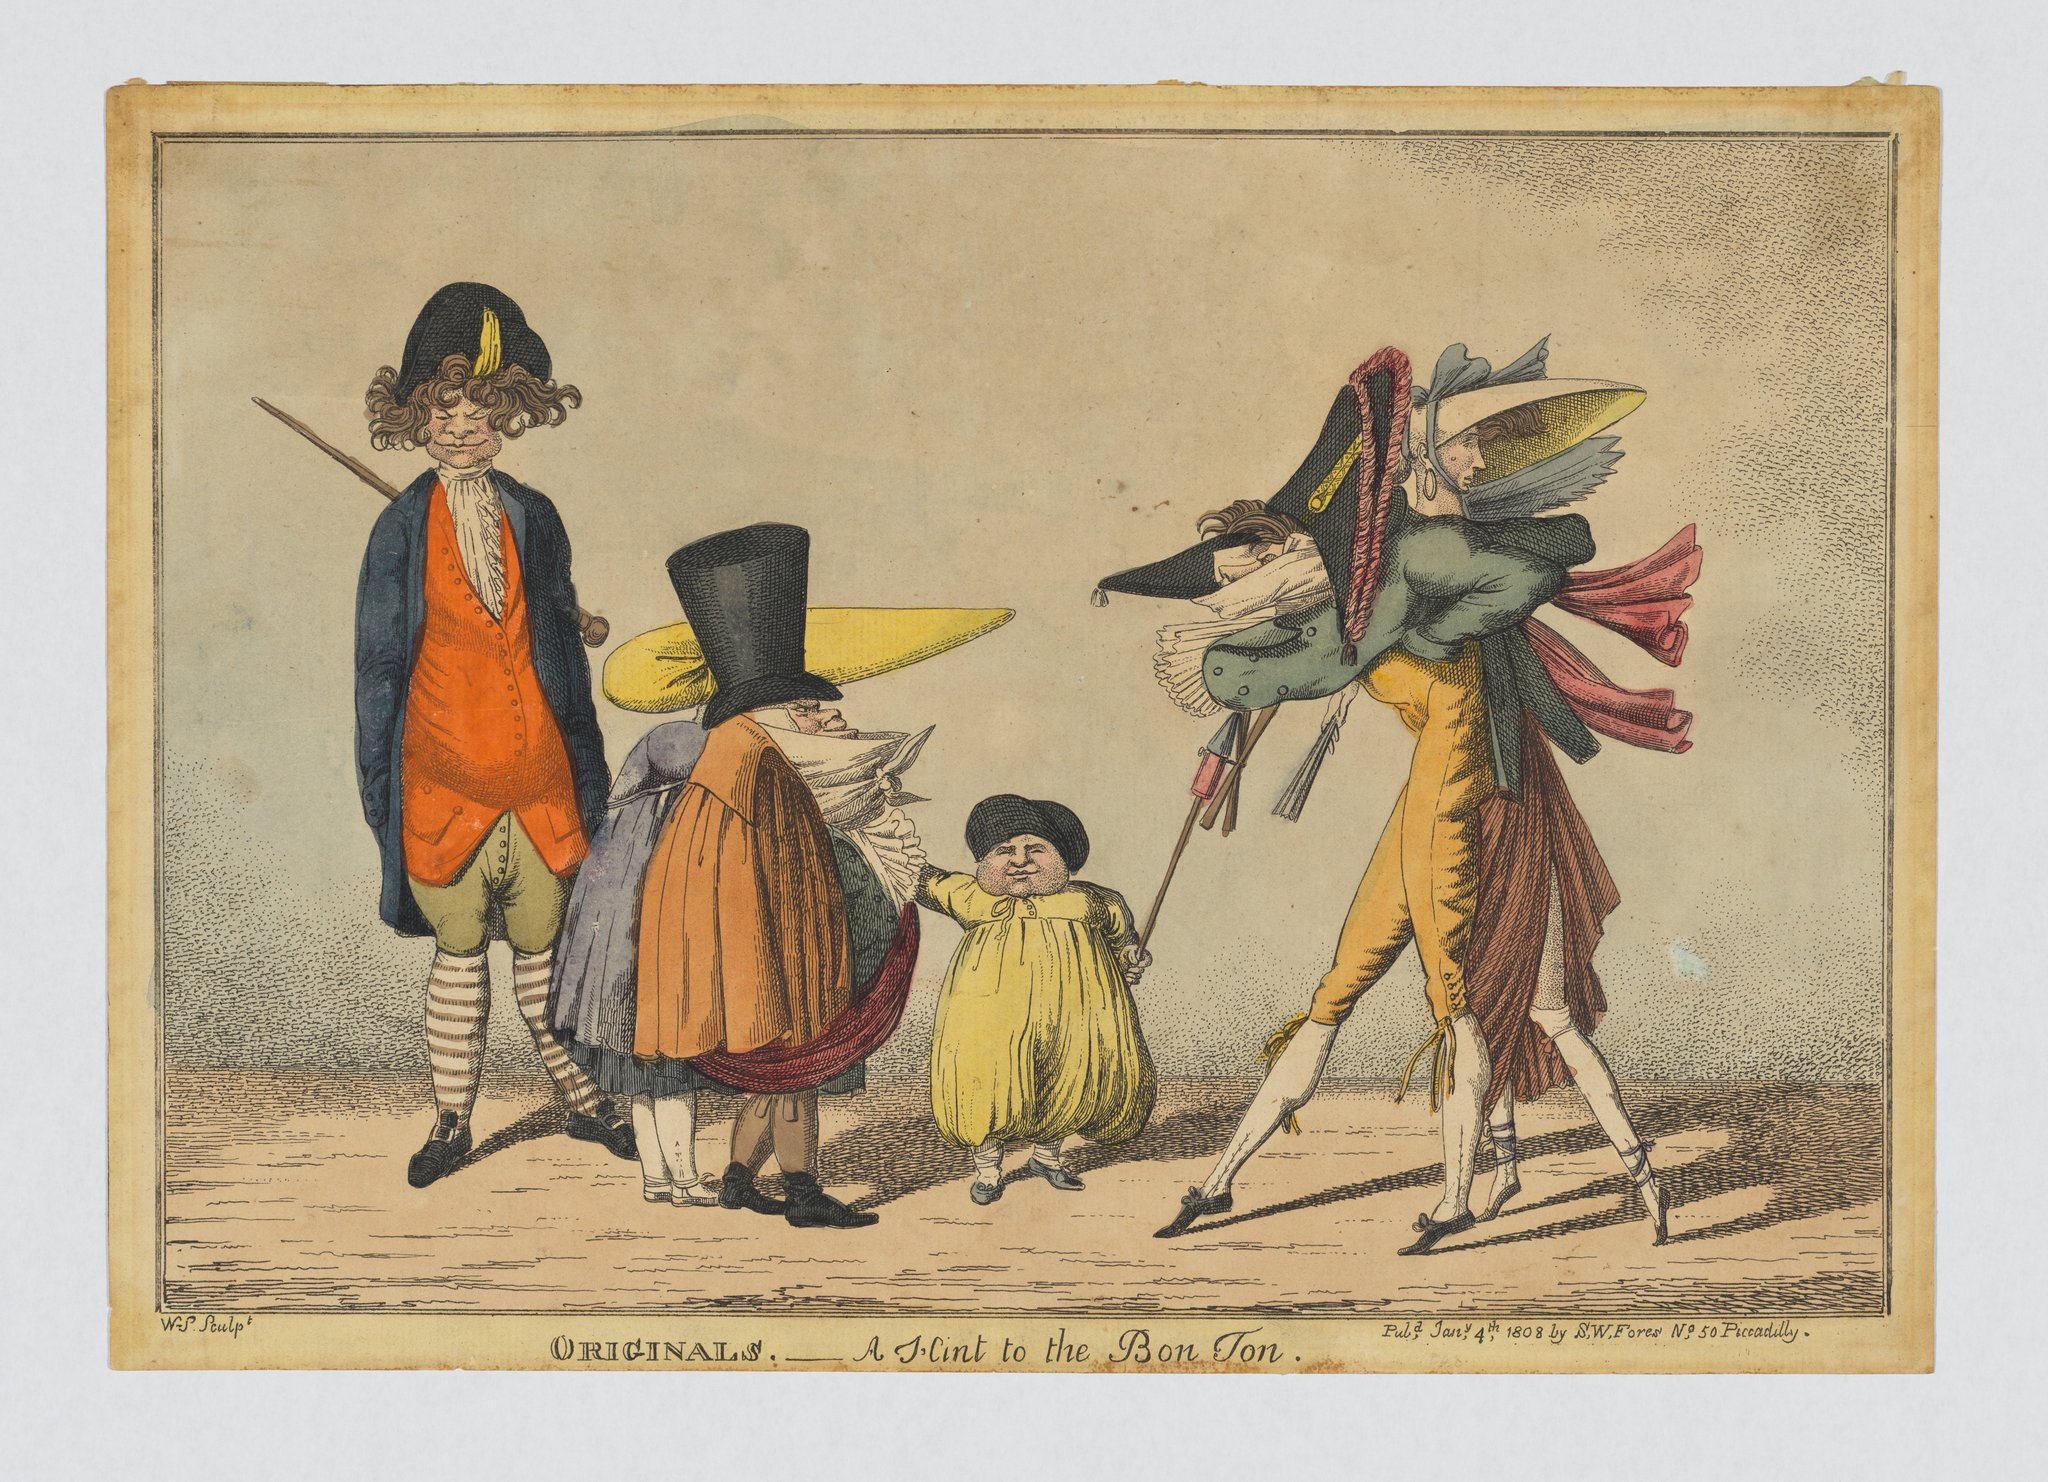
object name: print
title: Originals–A Hint to the Bon Ton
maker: charles williams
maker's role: artist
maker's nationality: british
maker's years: 1750-1850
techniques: etching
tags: satire,fashion